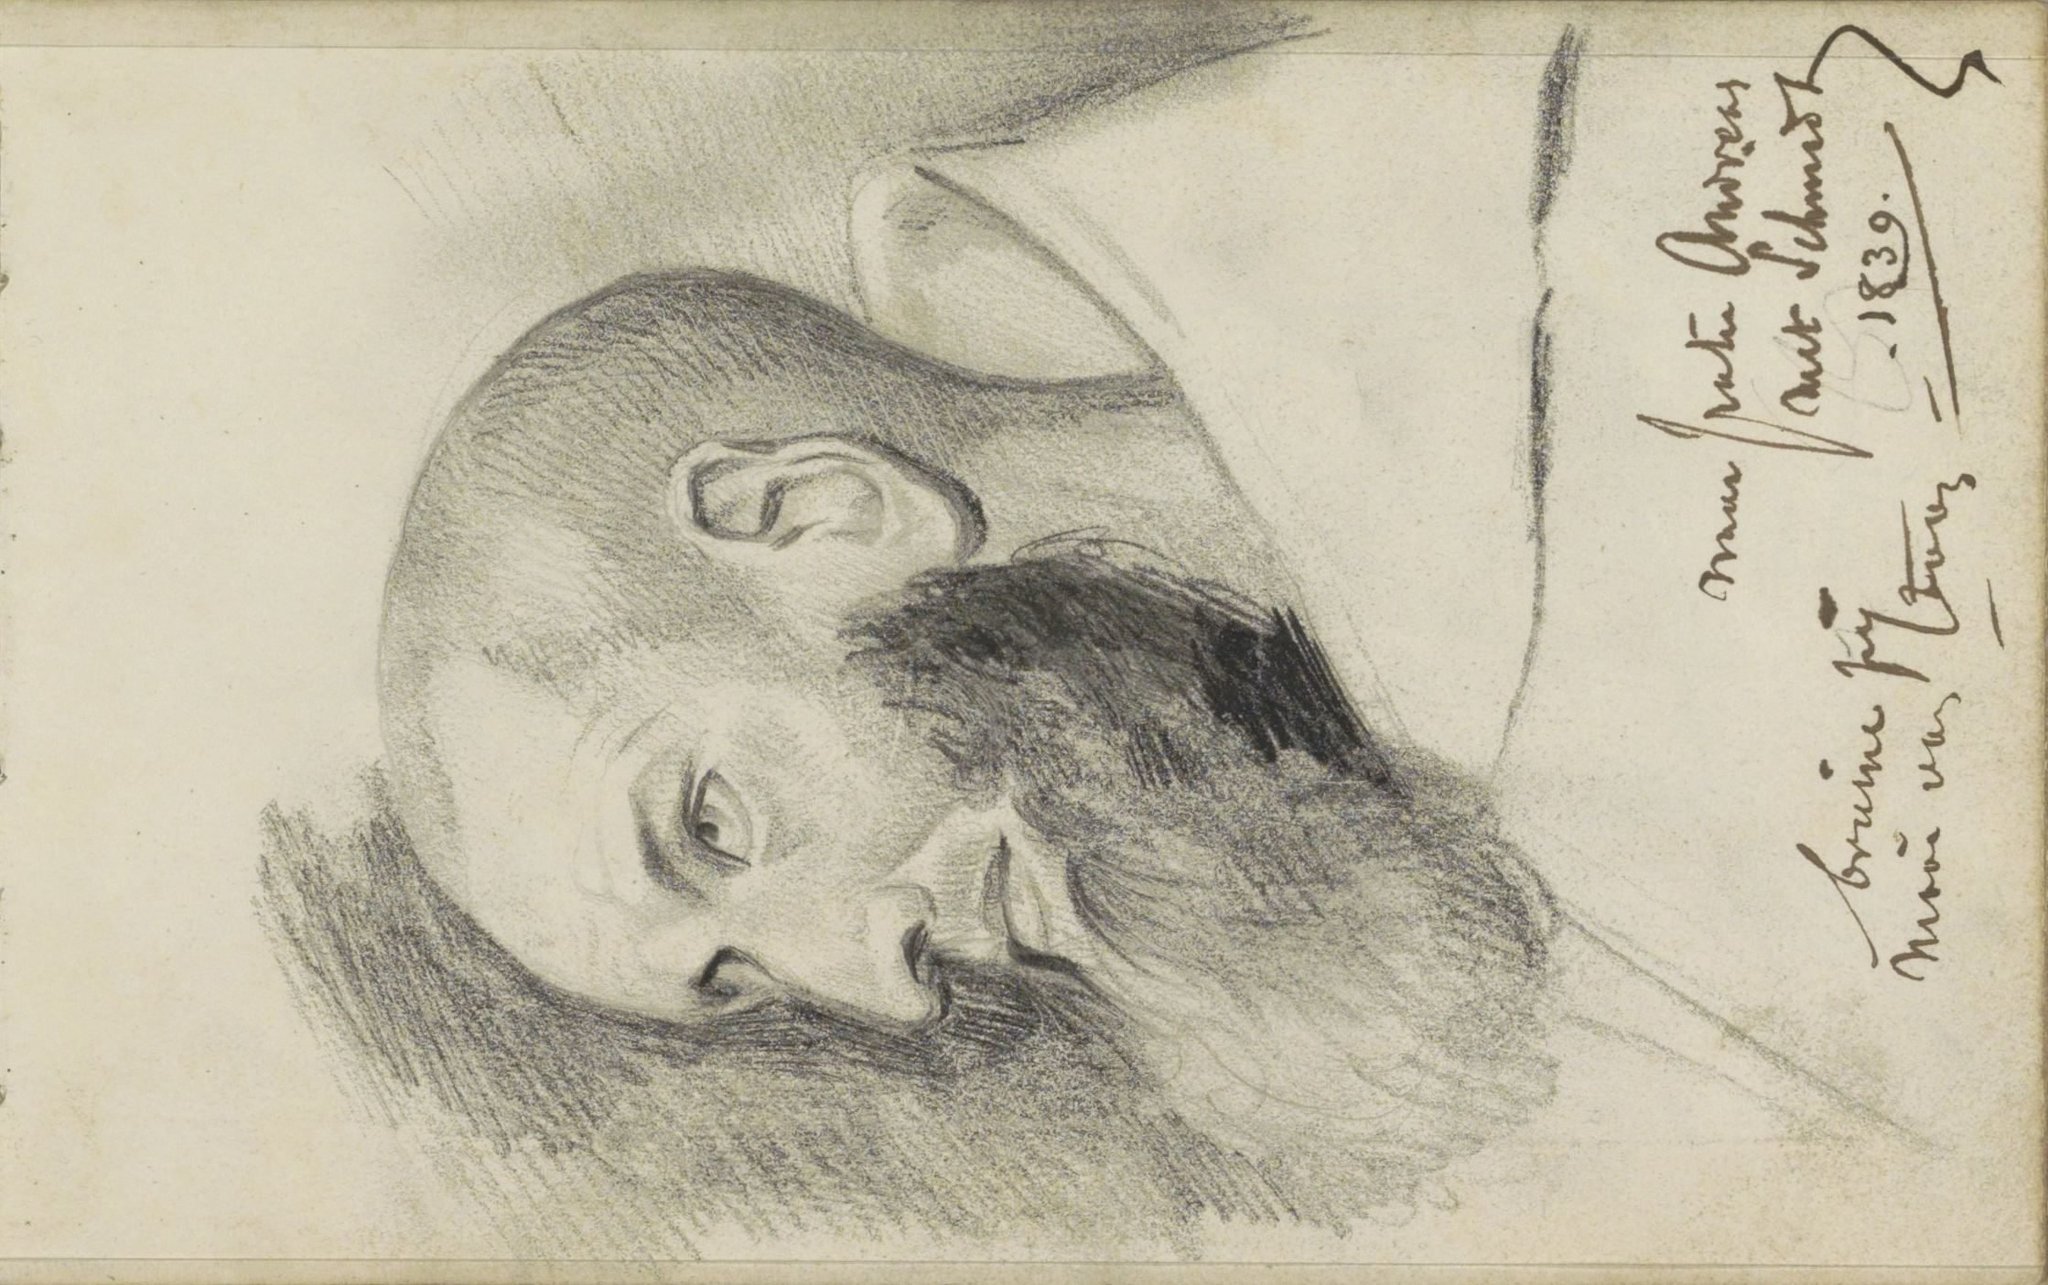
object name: sketchbook leaf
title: Pater Andreas van het Trappistenklooster Meirsel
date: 1839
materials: paper, pencil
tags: monk(s), friar(s)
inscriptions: date and inscription: ‘naar Pater Andreas/ met Schmidt/ .1939./ bruine pij/ mooi van toon -’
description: Blad 10 recto uit een schetsboek met 37 bladen.